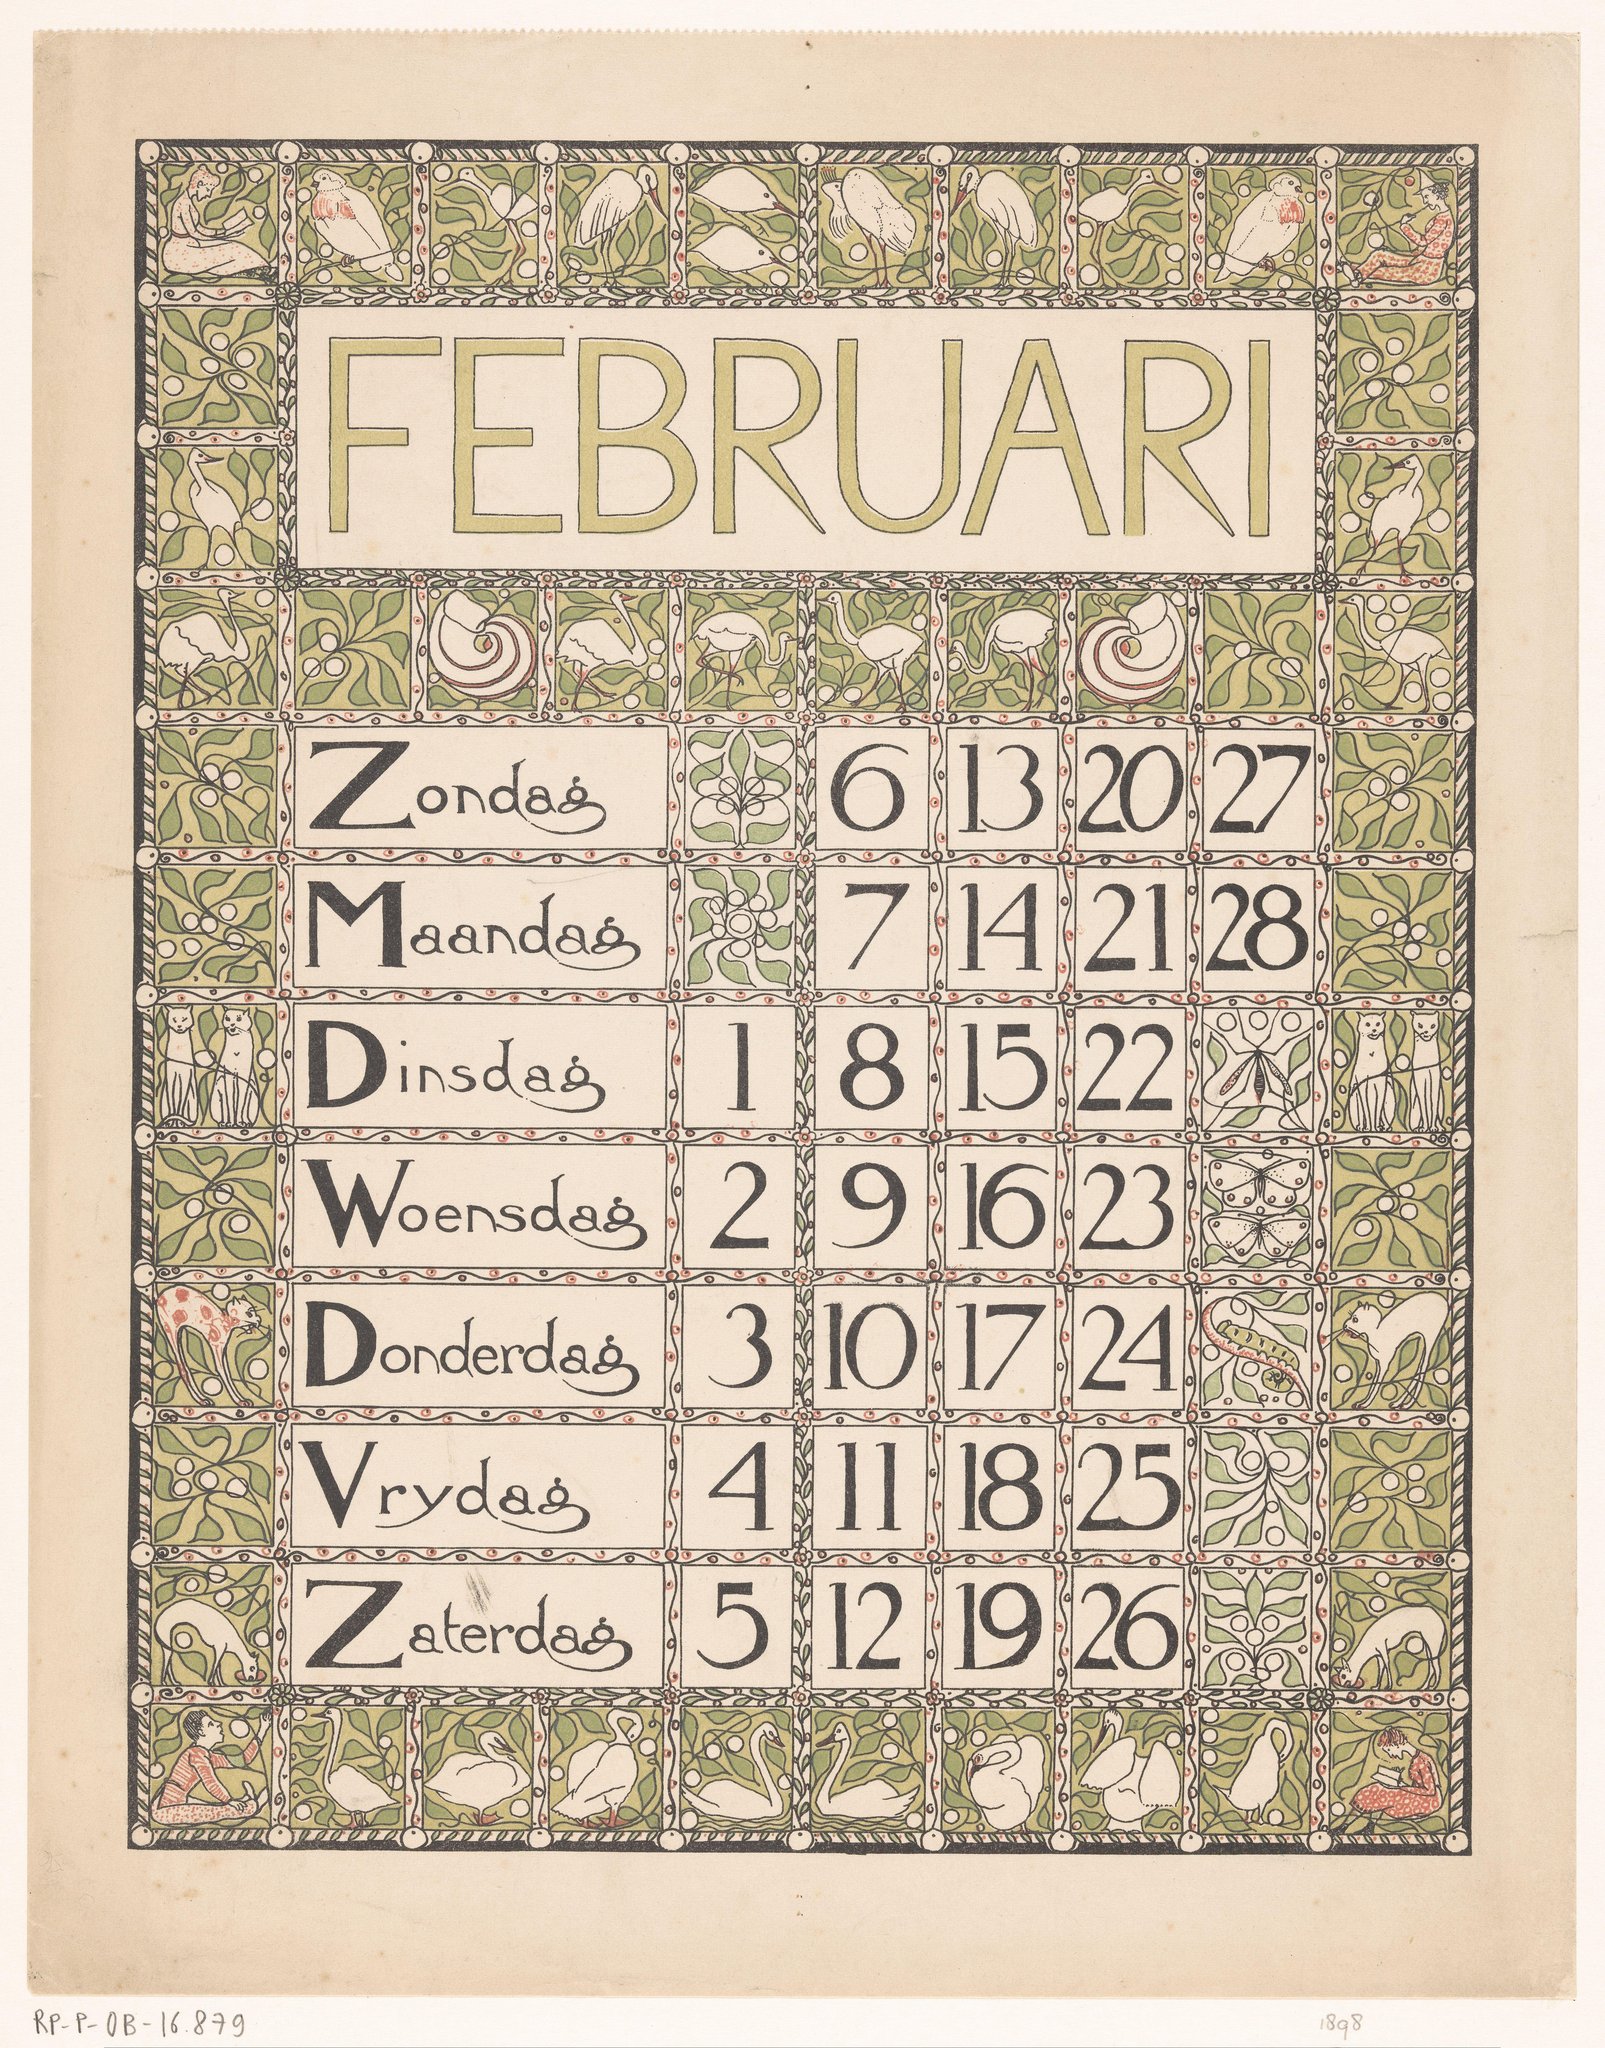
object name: calendar leaf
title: Kalenderblad voor februari 1898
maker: theo nieuwenhuis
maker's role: designer, draughtsman, print maker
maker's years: 1866-1951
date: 1897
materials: paper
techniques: lithograph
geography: amsterdam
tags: sitting figure, foliage ~ ornament, cat, birds, insects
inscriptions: collector's mark: Lugt 2228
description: Een rechthoekig kader opgevuld met de dagen van de maand februari en daaromheen katten, insecten, menselijke figuren en verschillende soorten vogels te midden van gebladerte.